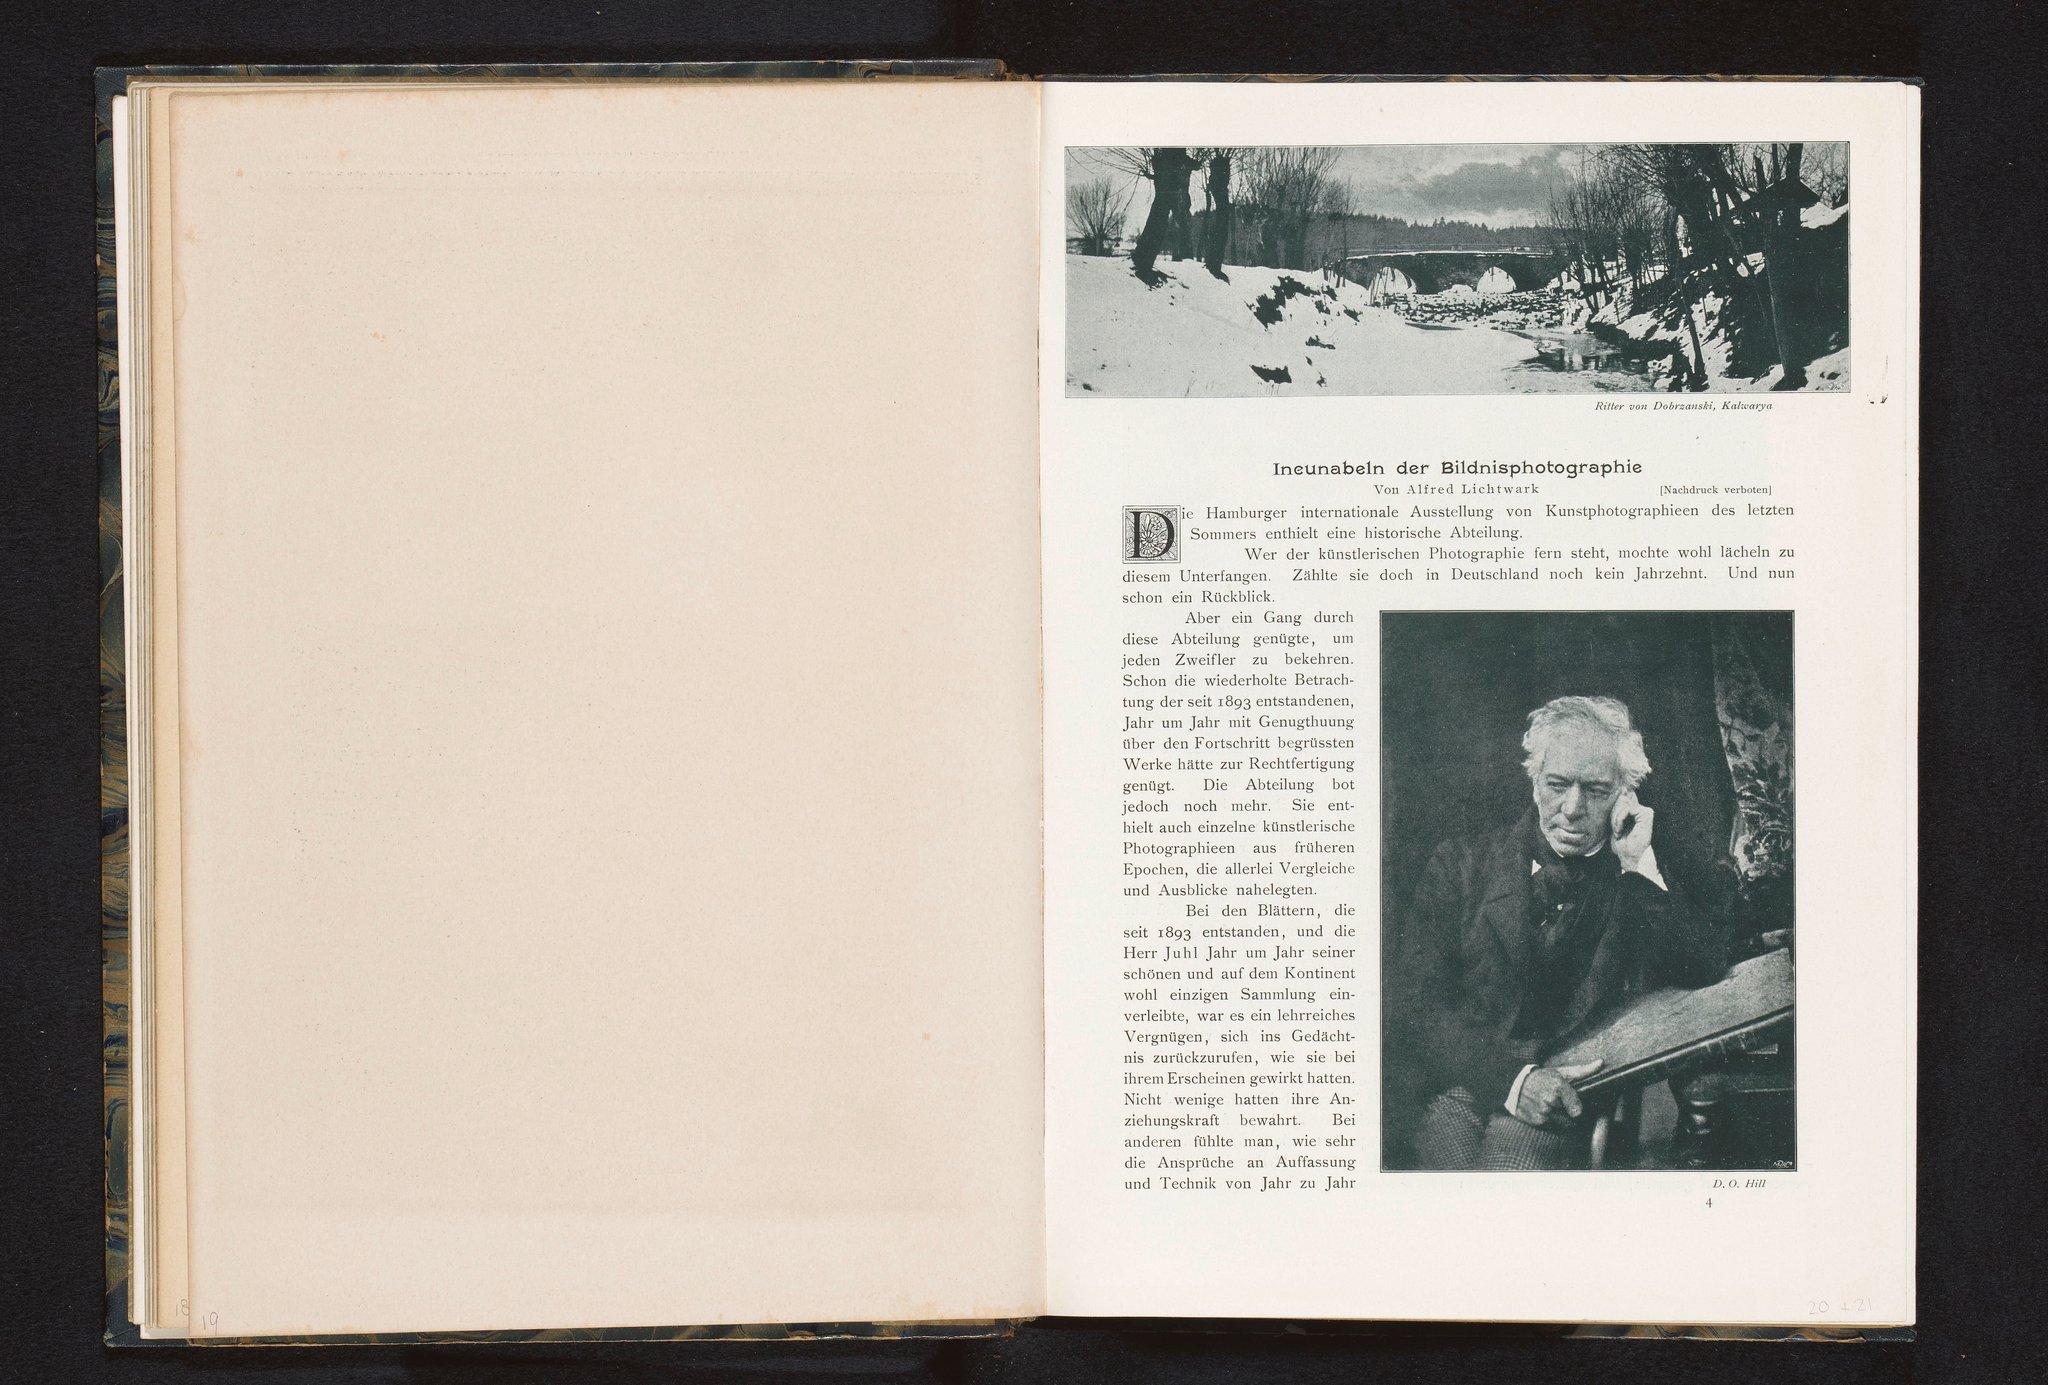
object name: page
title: Gezicht op een besneeuwd landschap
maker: ritter von dobrzanski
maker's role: fotograaf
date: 1895-1900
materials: paper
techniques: autotype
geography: berlin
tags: landscapes, snow